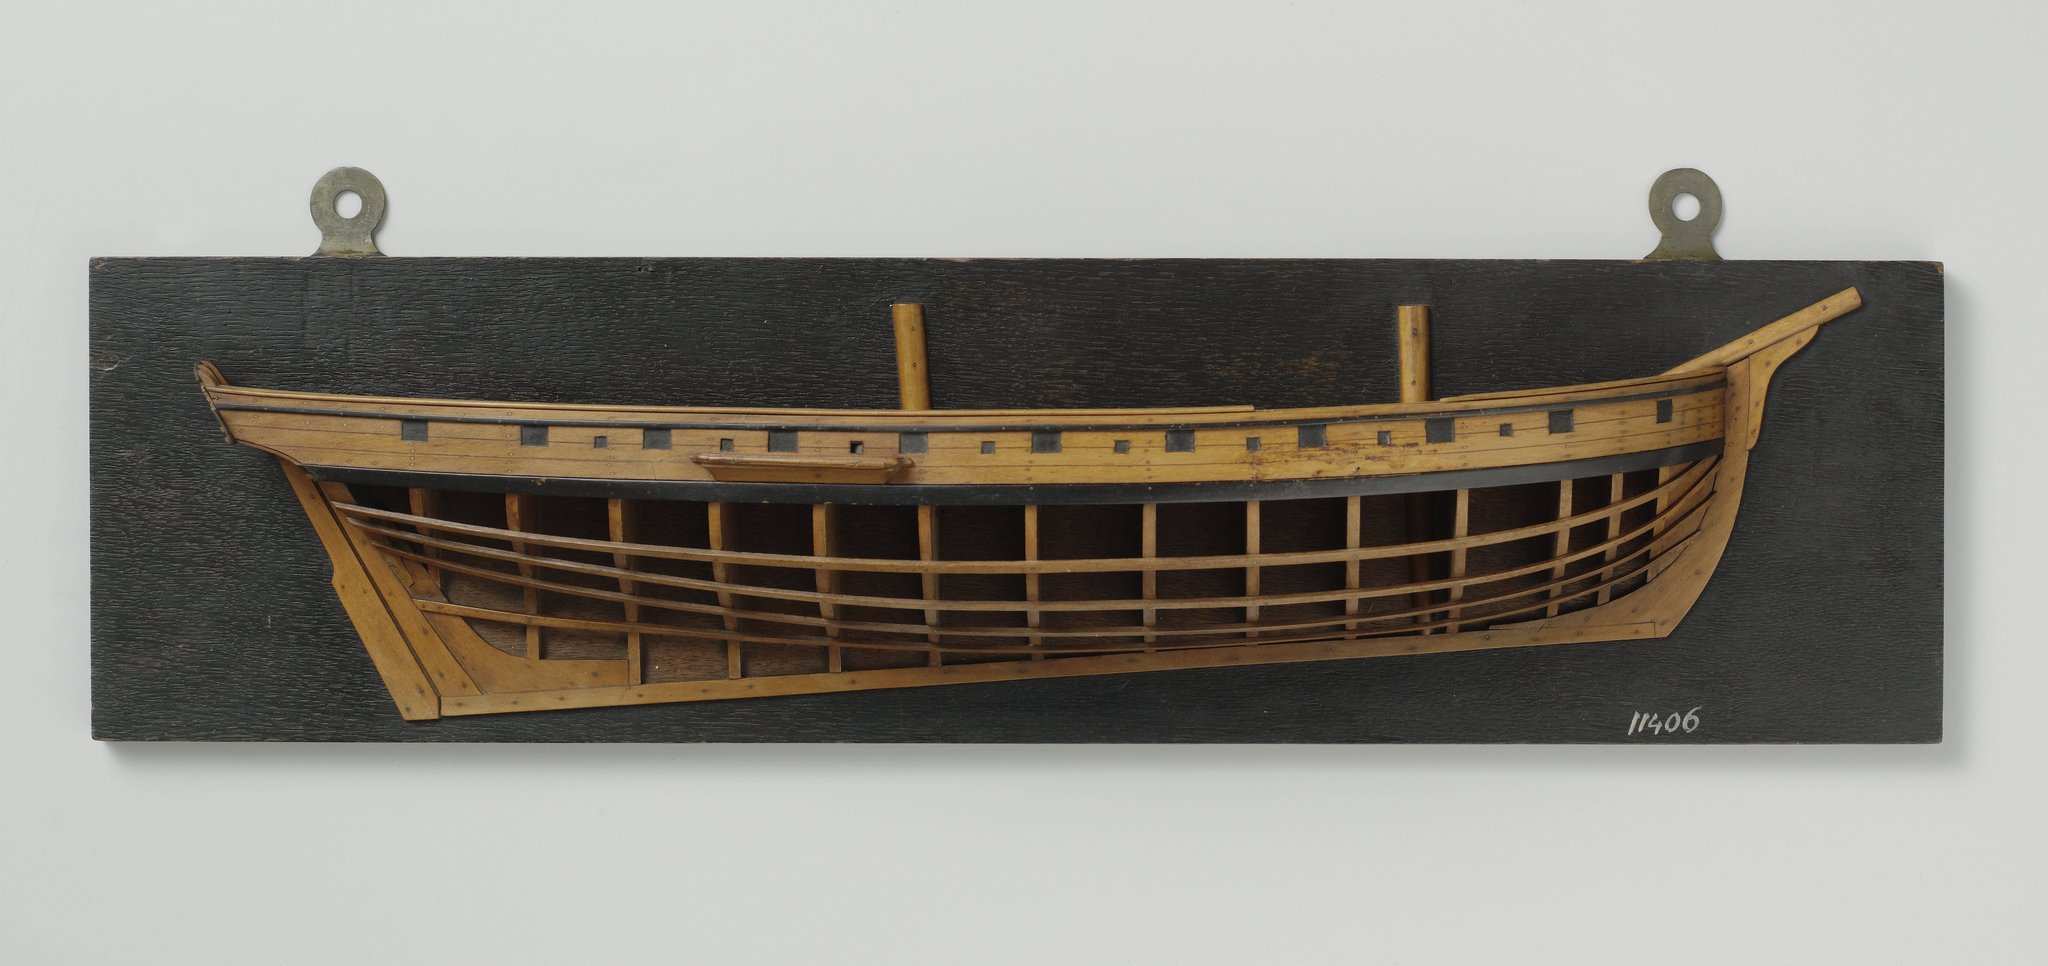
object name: ship model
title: Half Model of a Gunboat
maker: Anonymous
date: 1400-1950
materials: wood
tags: ship-model (+ propulsion of vehicle, ship, etc. by wind)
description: Halfmodel van een zeilkanonneerboot (spanten en centen) met twee masten.